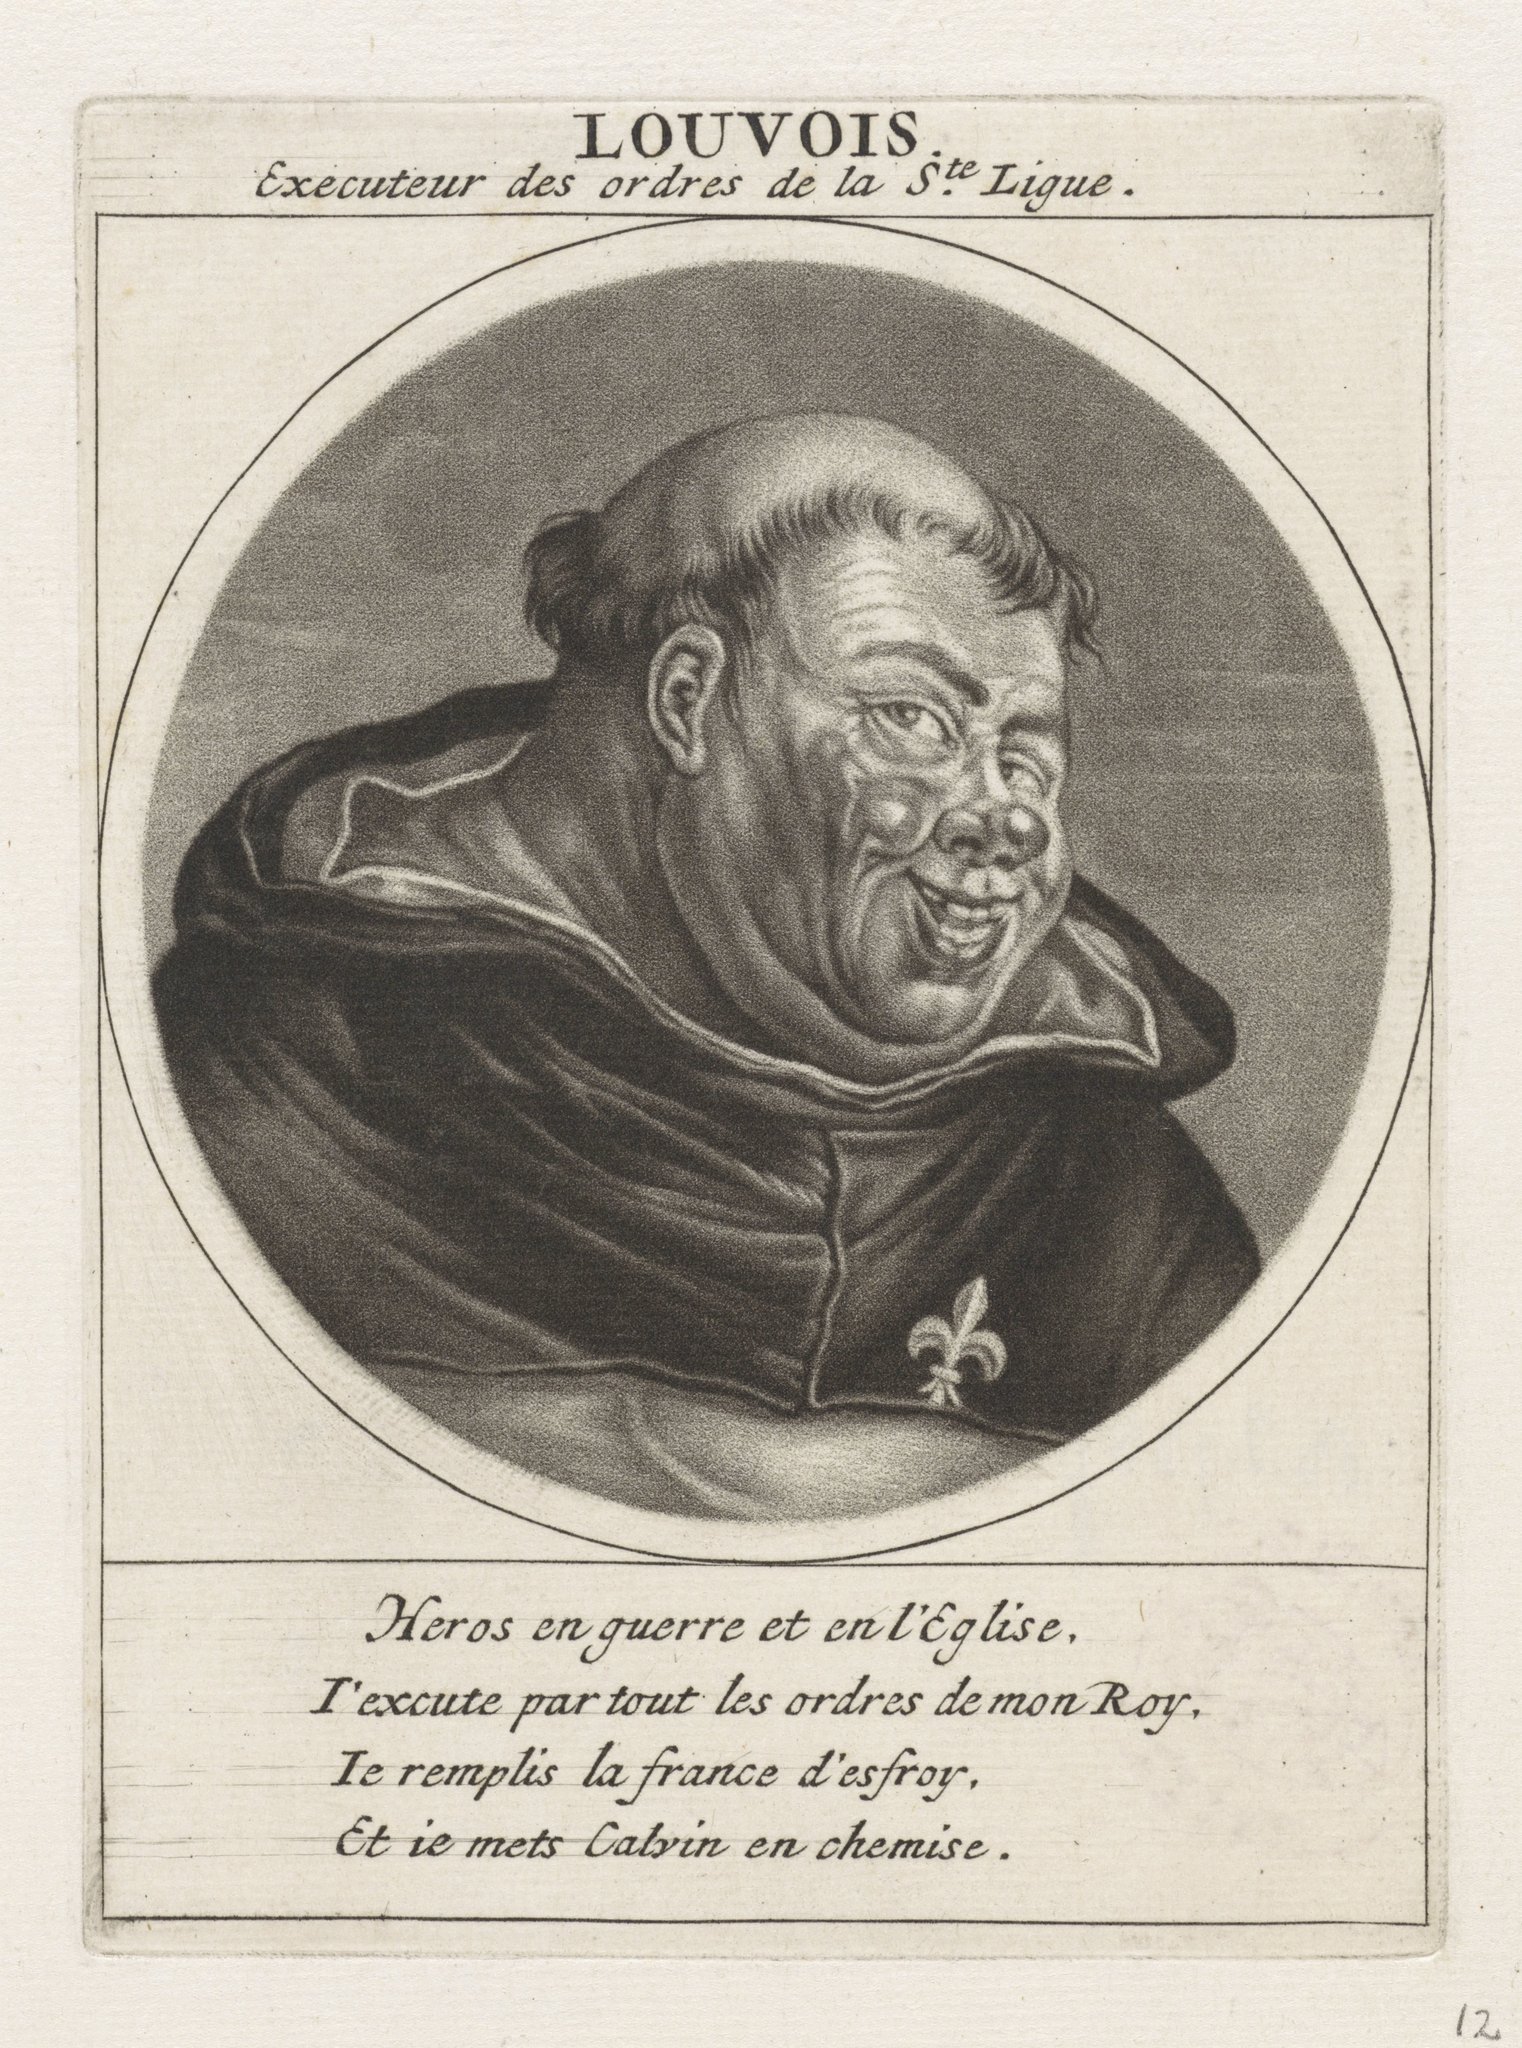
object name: print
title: The Heroes of the League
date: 1691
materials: paper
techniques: engraving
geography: paris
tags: paris, françois-michel le tellier (markies de louvois), fleur-de-lis ~ ornament, political caricatures and satires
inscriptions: collector's mark: Lugt 240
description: Cornelis Dusart and Jacob Gole collaborated on these two series of virulent anti-Catholic caricatures. This one consists of satirical portraits of the architects and agents of the policy of Protestant oppression under Louis XIV. Jacob Gole himself was a Huguenot refugee from France. These champions of Louis’s Catholic politics are presented as monks wrapped up in drinking and dicing.